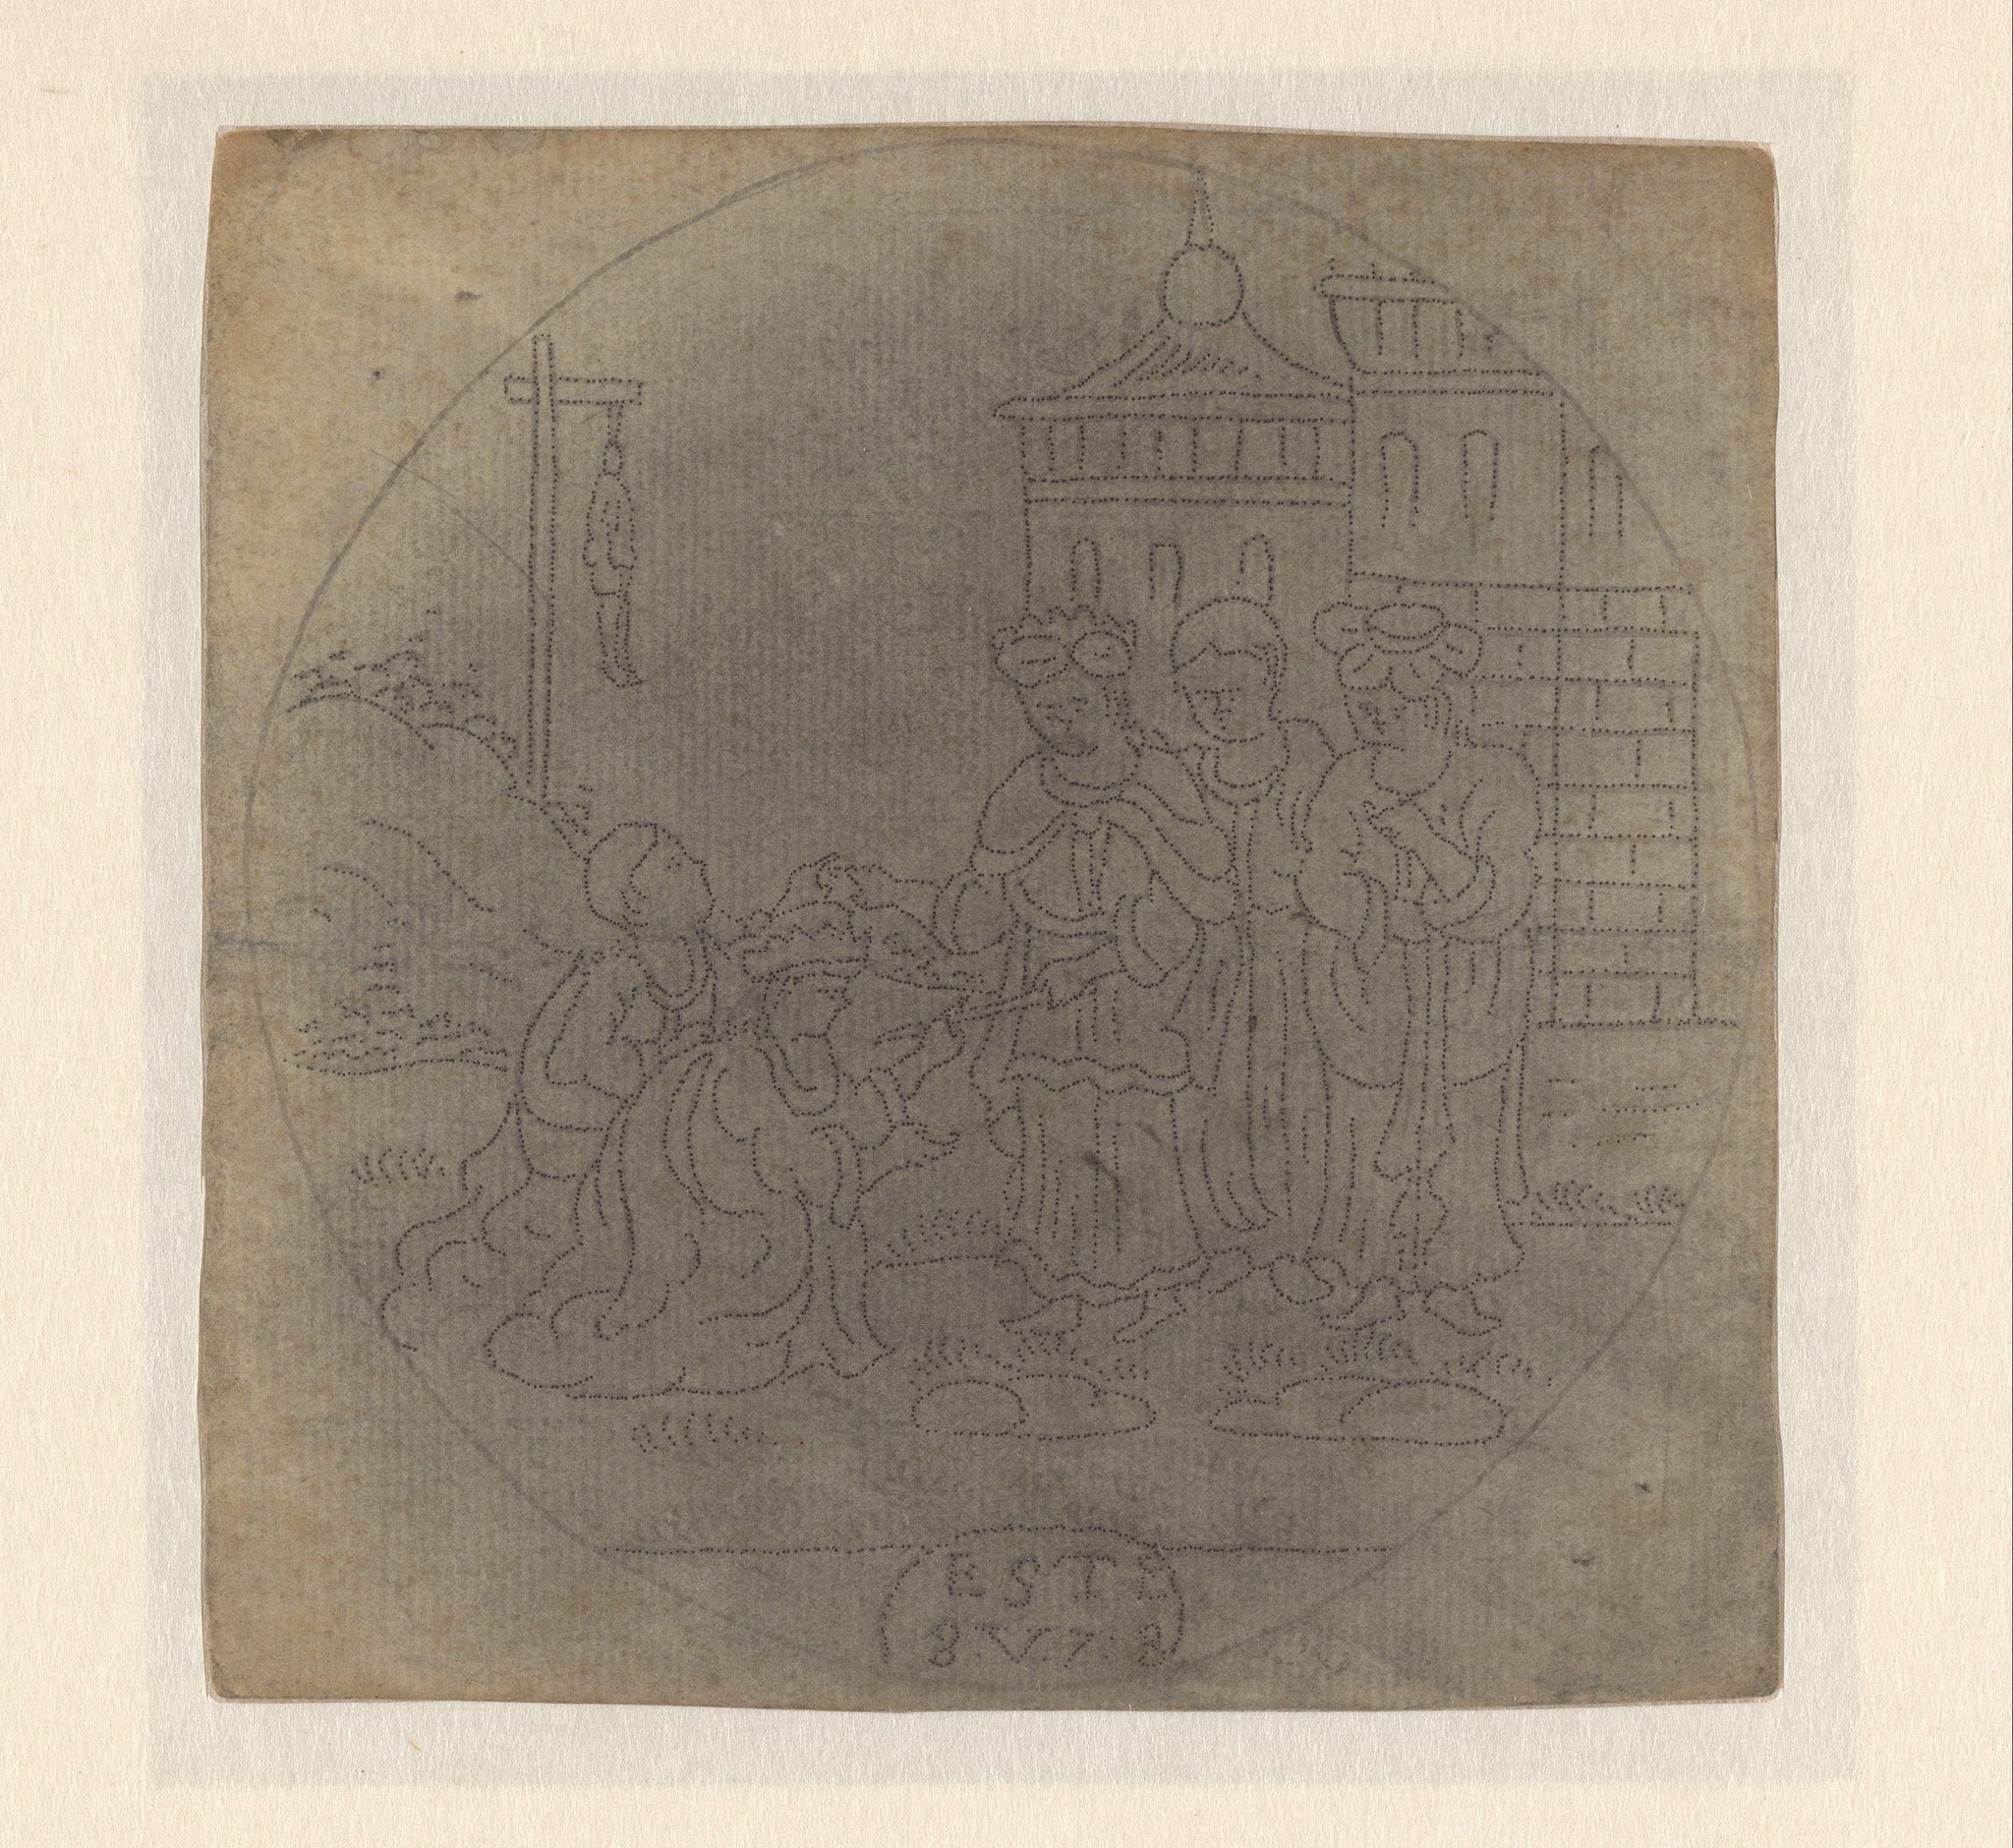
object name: punchwork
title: Pons of spons voor het beschilderen van tegels met de voorstelling van Esther 8: 7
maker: Anonymous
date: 1700-1799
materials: paper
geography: netherlands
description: Op papier geponste voorstelling van vijf figuren, drie staande en twee knielende, met een gebouw en op de achtergrond een galg. Esther 8: 7.